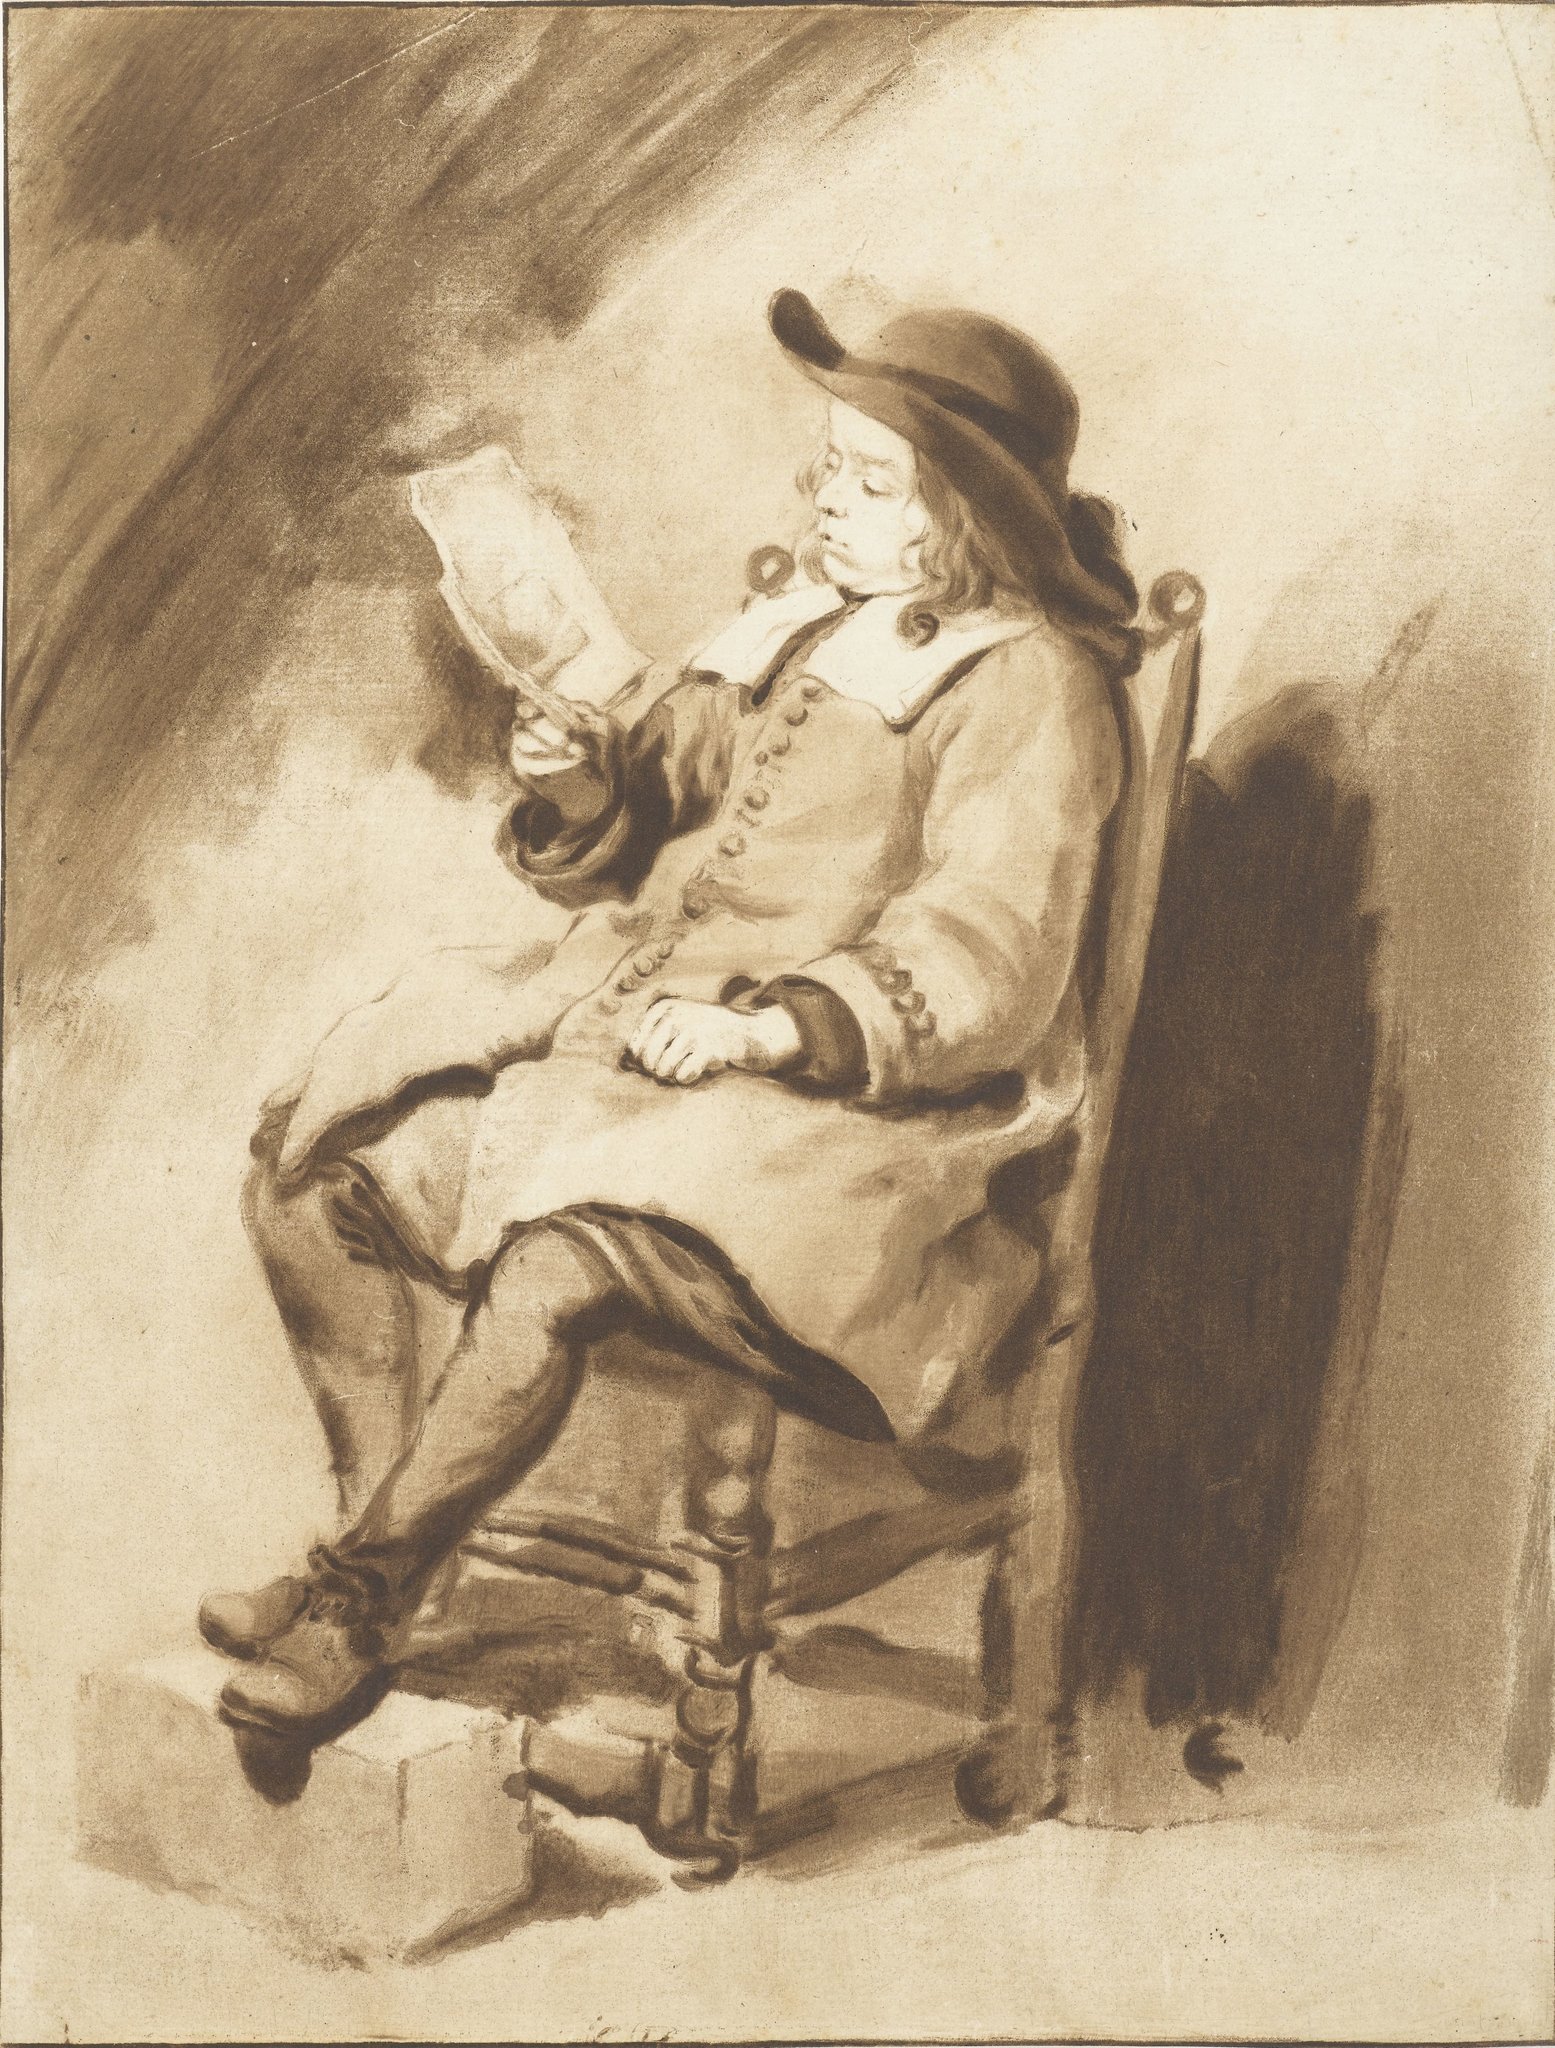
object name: print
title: Lezende jongeling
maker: jurriaan cootwijck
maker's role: print maker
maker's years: 1714-1798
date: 1724-1798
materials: paper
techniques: print drawing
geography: amsterdam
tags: reading, youth, adolescent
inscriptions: collector's mark: Lugt 12, collector's mark: Lugt 2725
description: Een jongeling in een leunstoel leest een blad papier.